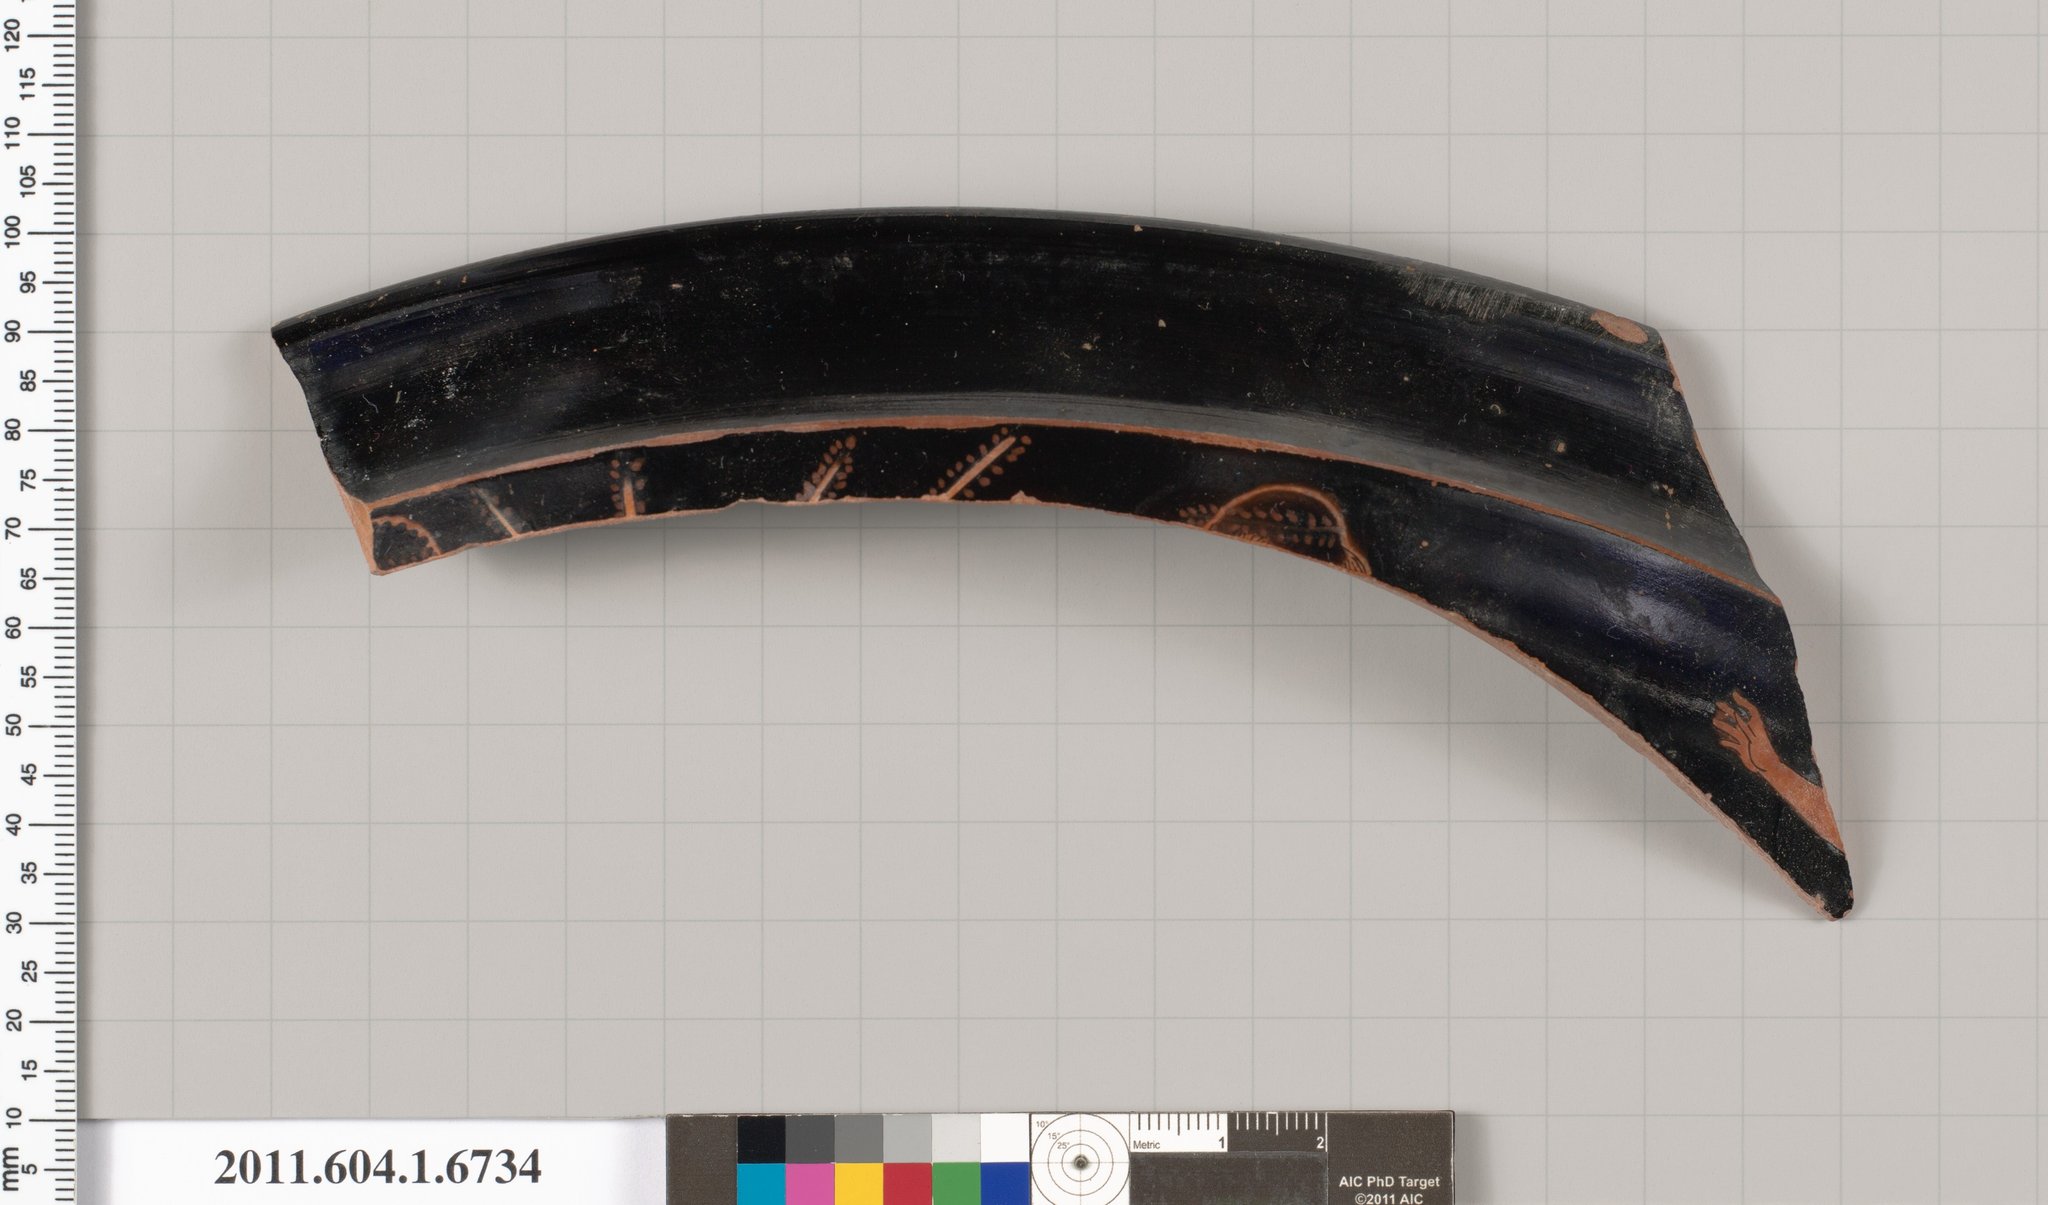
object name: kylix fragment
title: Terracotta rim fragment of a kylix (drinking cup)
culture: greek, attic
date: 490-470 BCE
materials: terracotta